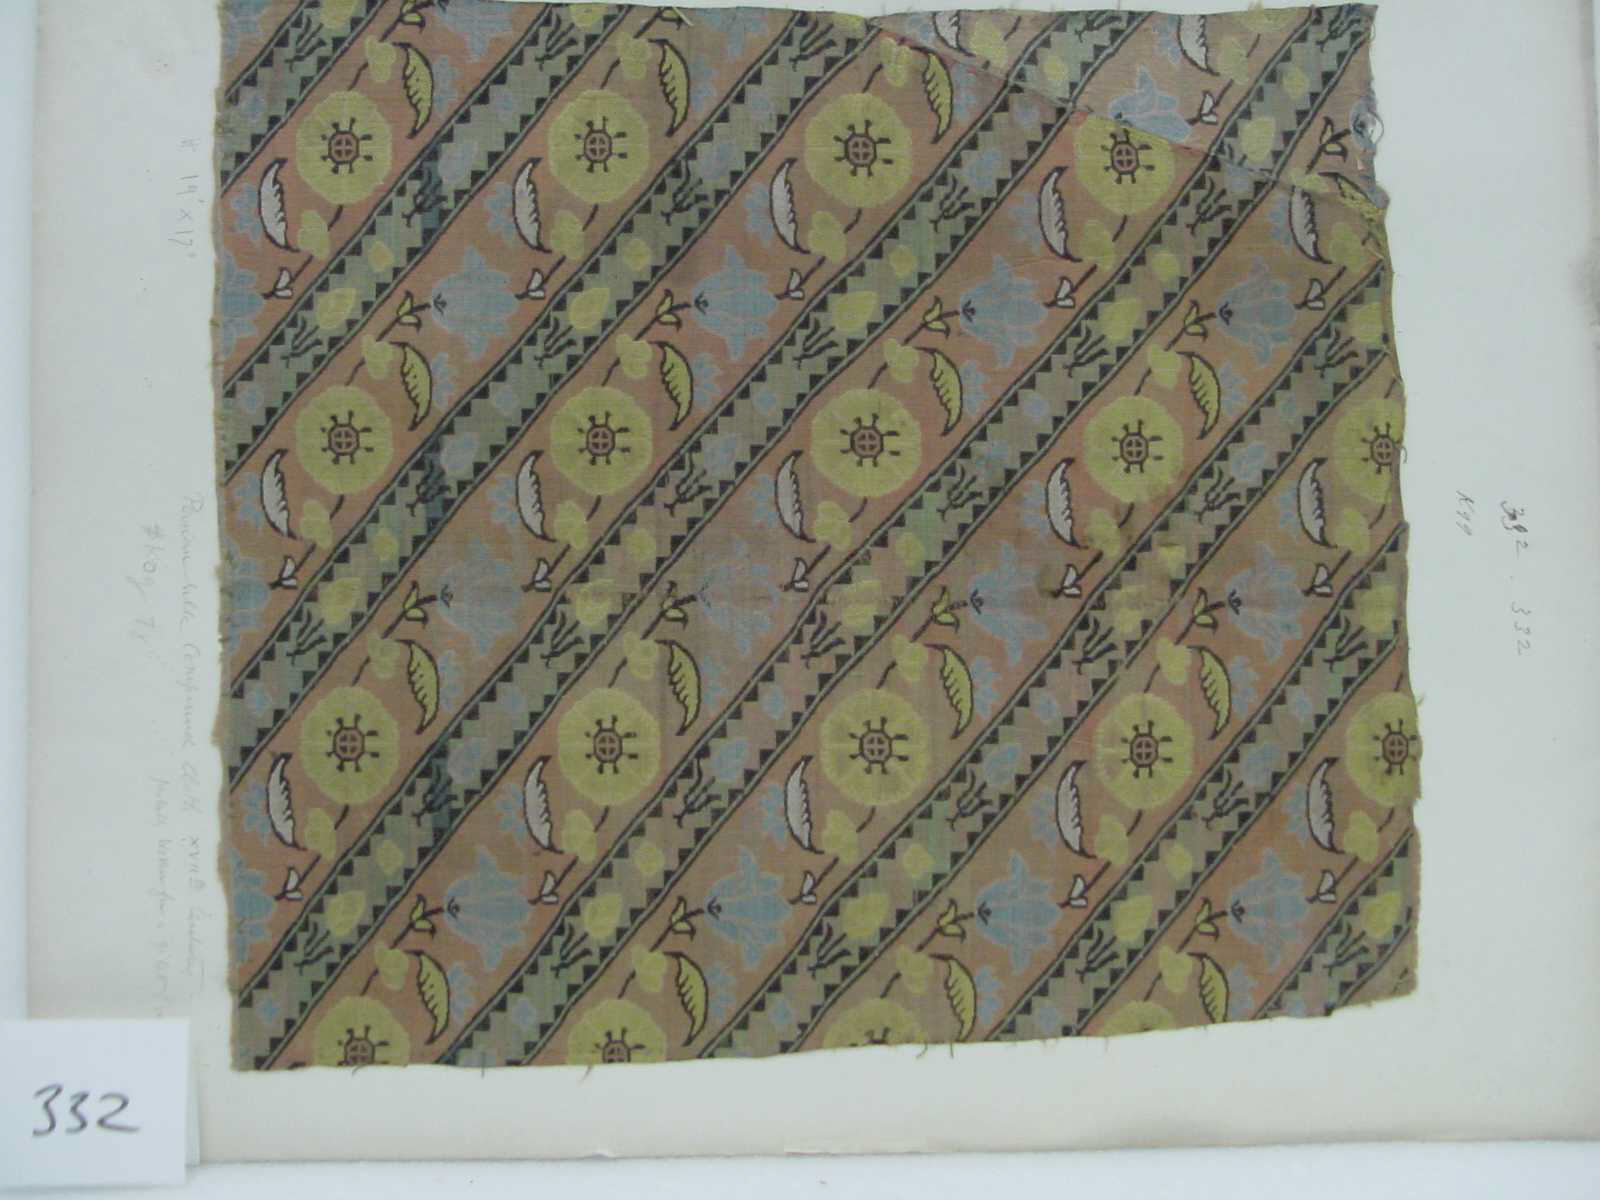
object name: textile fragment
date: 1601-1700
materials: silk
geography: iran